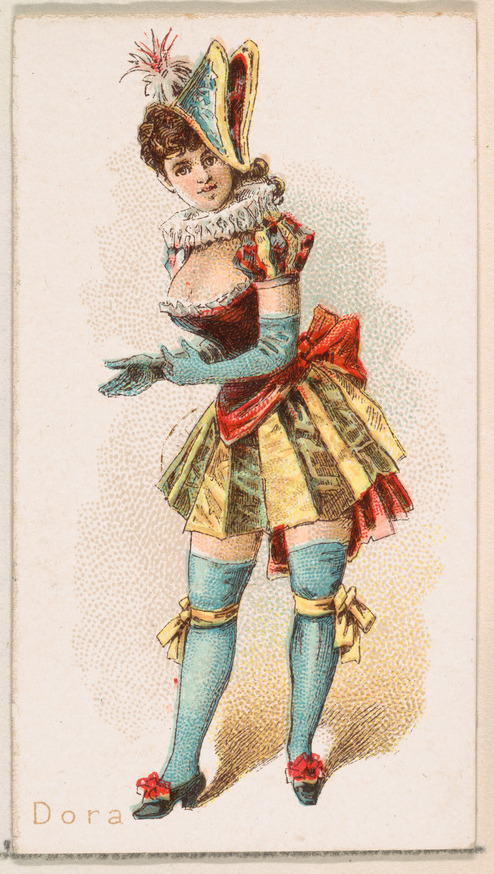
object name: print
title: Dora, from the Ballet Queens series (N182) issued by Wm. S. Kimball & Co.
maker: william s. kimball & company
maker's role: publisher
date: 1889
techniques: color lithograph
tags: women